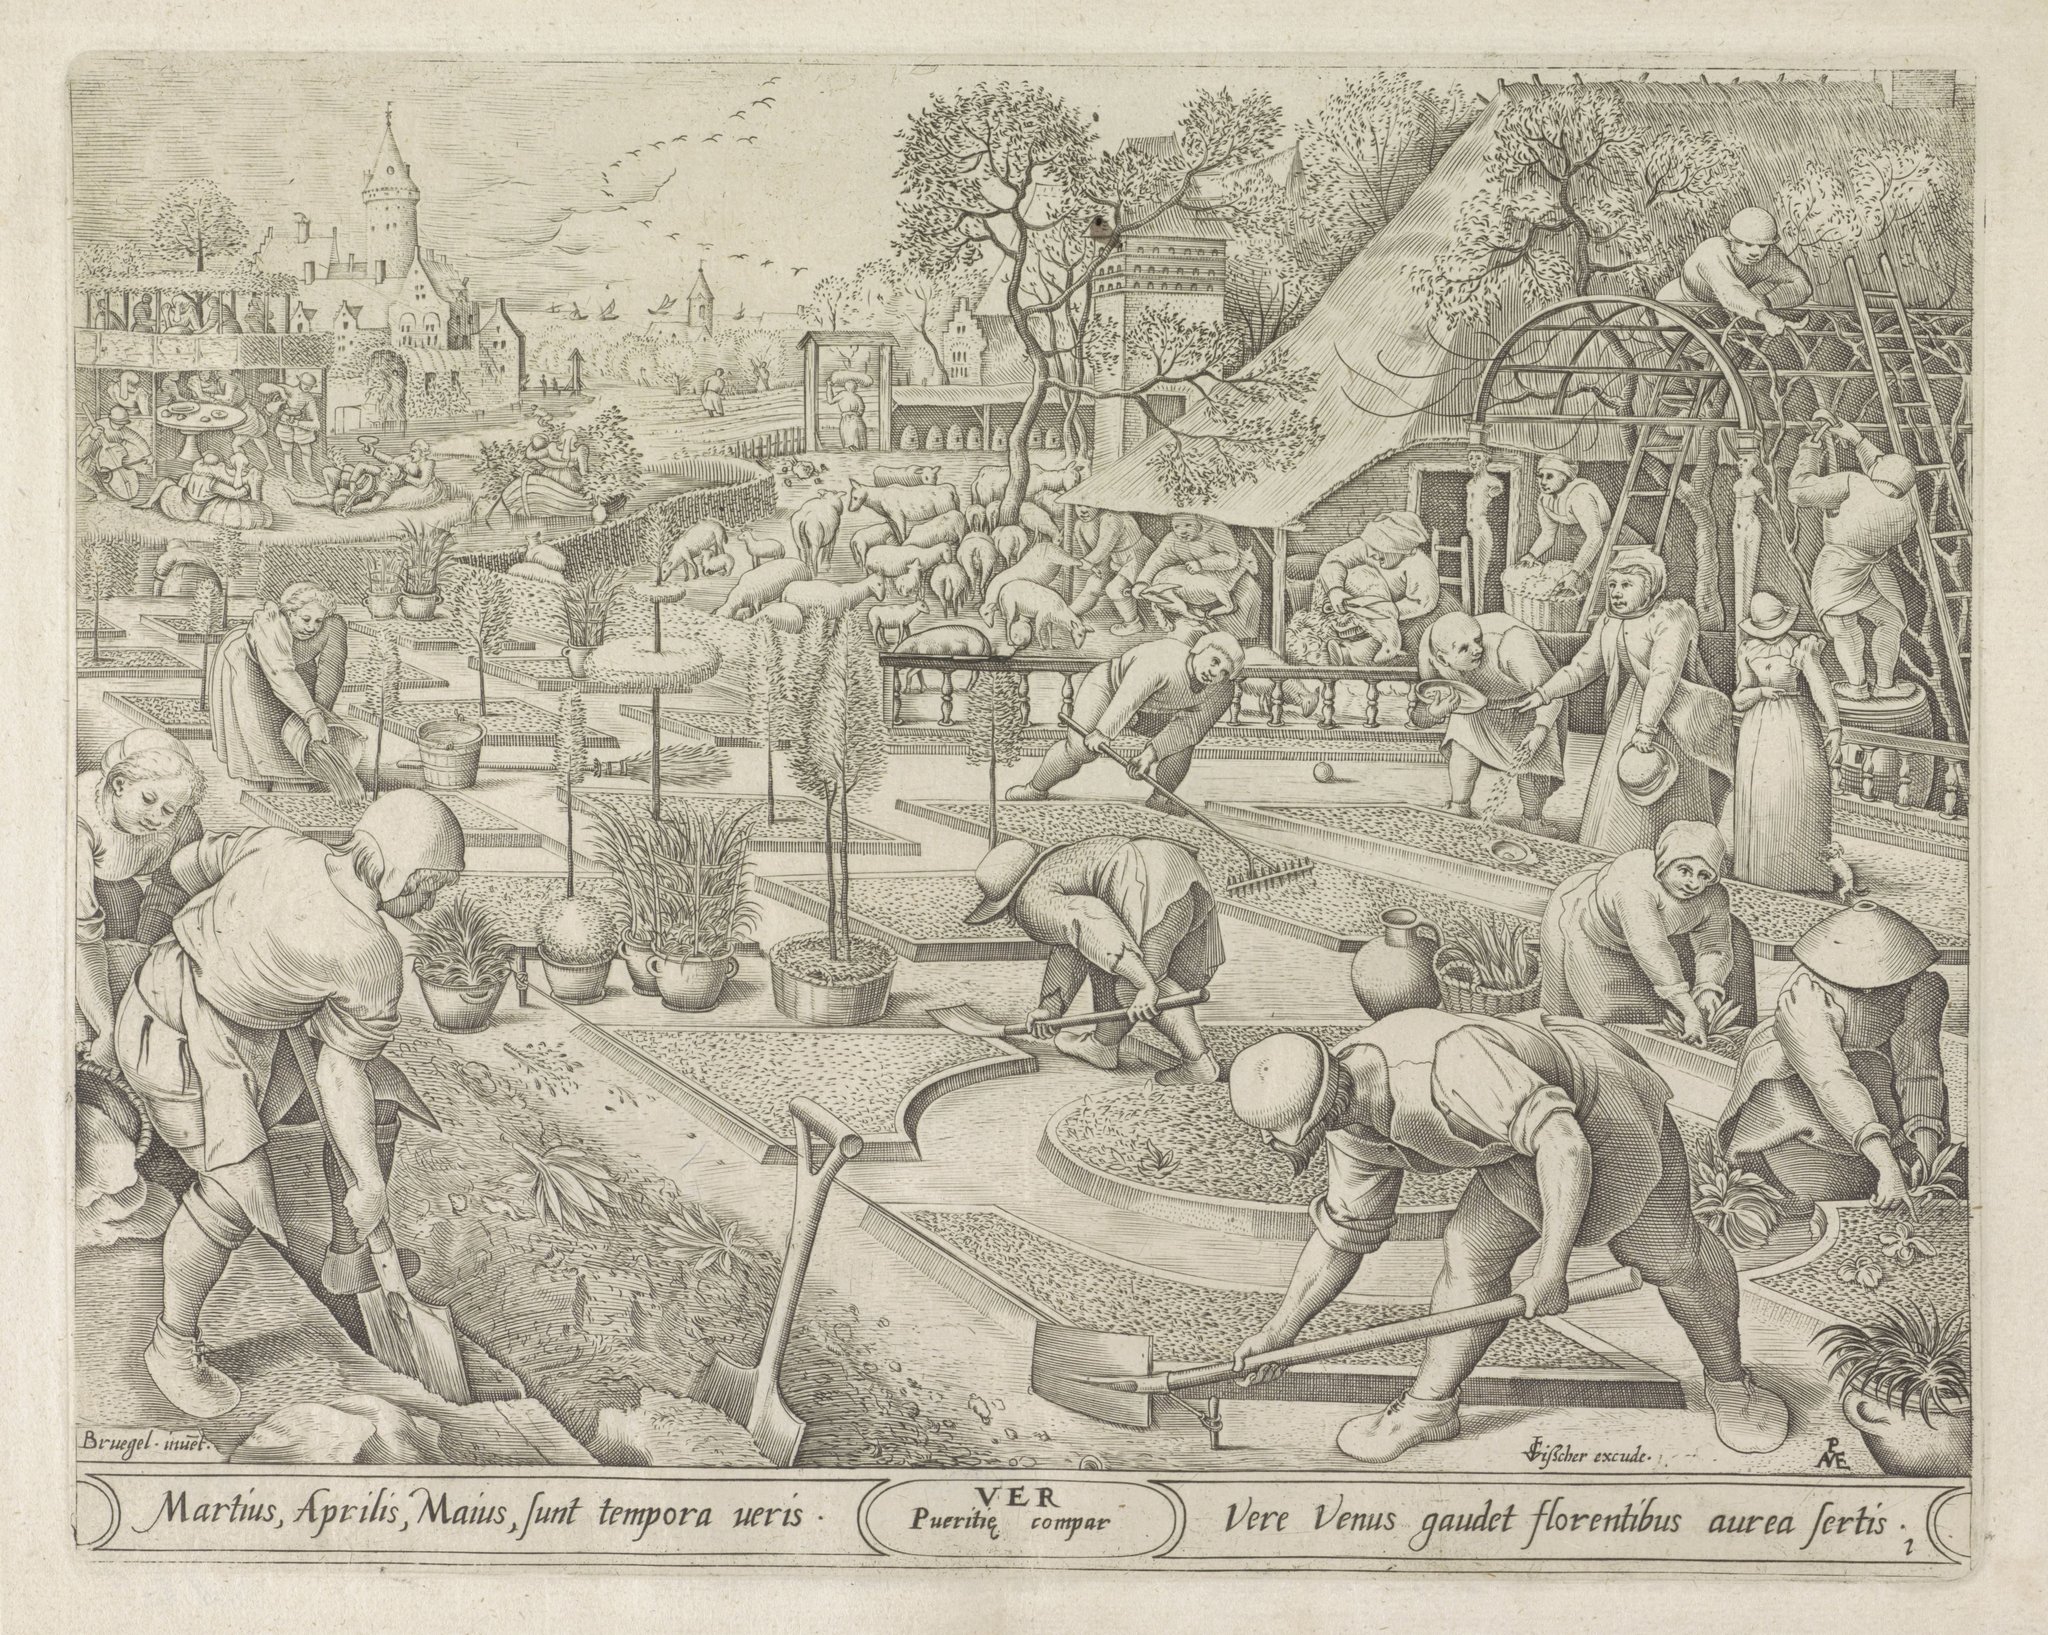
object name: print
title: Lente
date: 1570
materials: paper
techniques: engraving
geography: amsterdam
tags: spring ~ human activities (the four seasons of the year), gardening, outdoor gathering, 'délices à la campagne', shearing (sheep)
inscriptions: collector's mark: Lugt 2228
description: Het seizoen van de lente: de maanden maart, april, mei. Het planten en zaaien, spitten en harken in een aangelegde tuin. Rechts een dame die orders geeft aan de werkers. Op de achtergrond het scheren van schapen en linksachter een etend en drinkend gezelschap in een prieel. Onder de voorstelling een tekst in het Latijn.